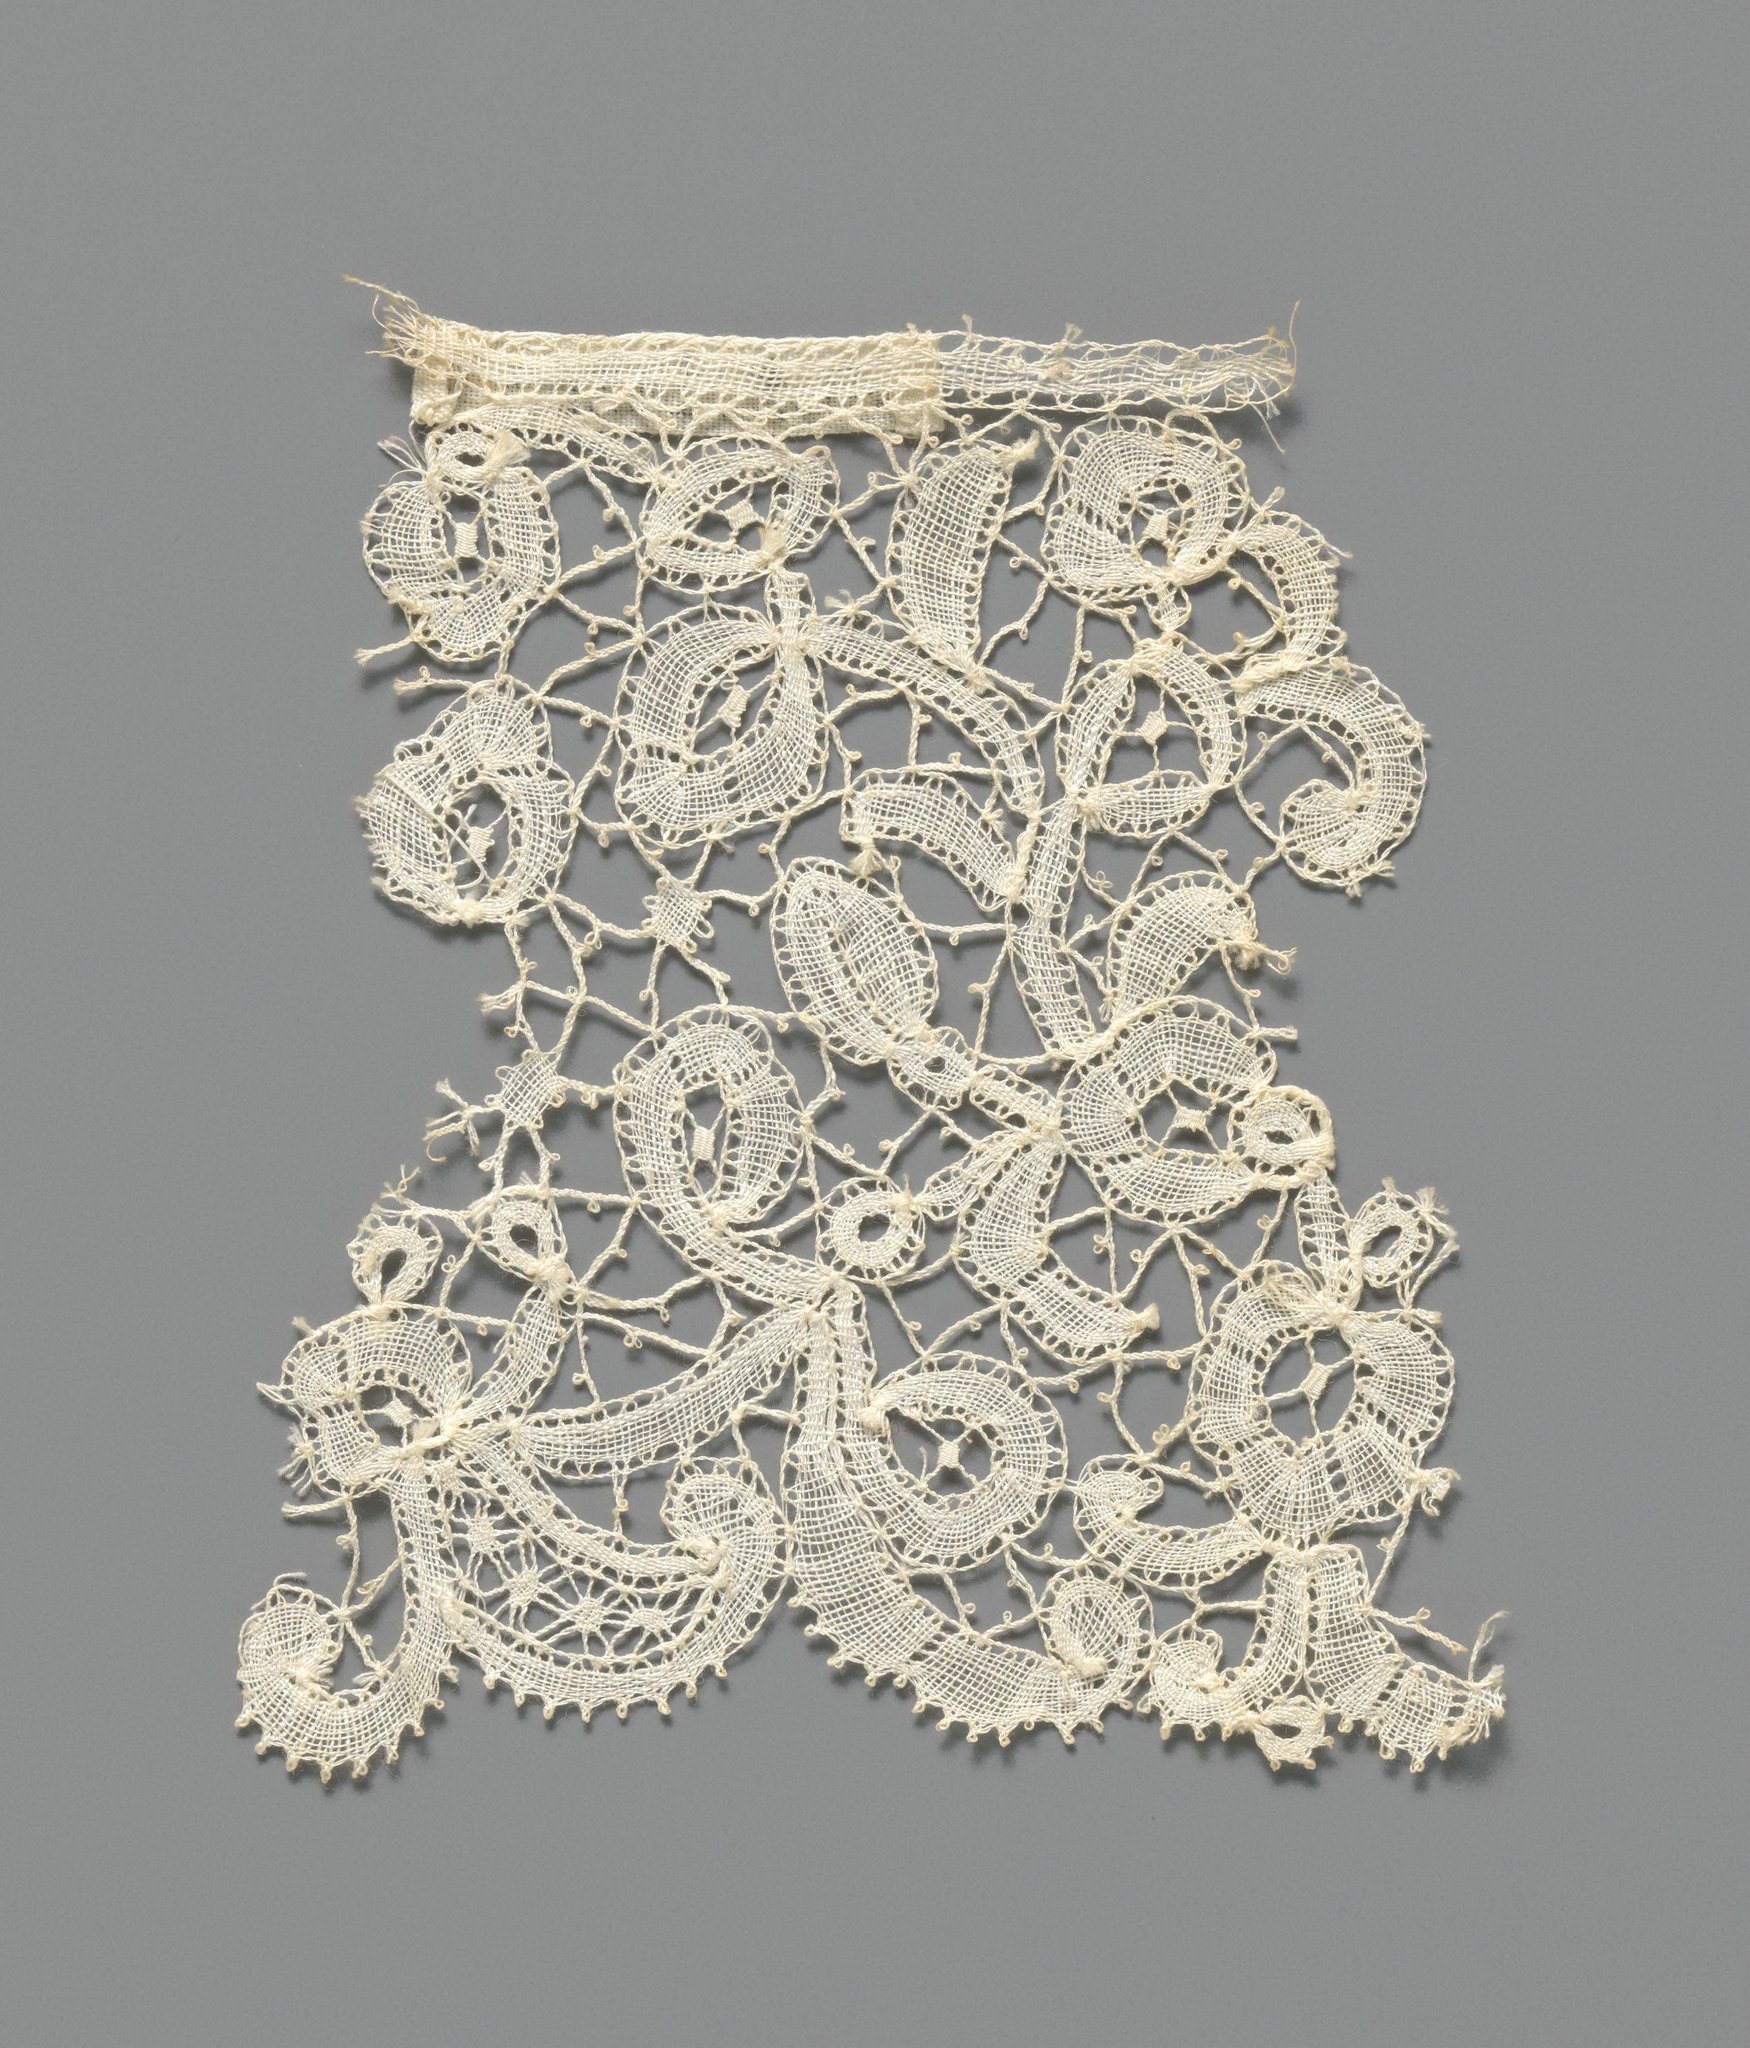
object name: strip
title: Strook kloskant met verschillende ovale bloempjes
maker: Anonymous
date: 1925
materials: linen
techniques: lace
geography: bruges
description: Strook naturelkleurig kloskant: fijn Brugs bloemwerk. Het patroon dat te zien is op het korte stuk strook bestaat uit verschillende ovale bloempjes die met korte ranken en blaadjes met elkaar verbonden zijn. De motieven zijn gemaakt in linnenslag, met opengewerkte randjes en dunne contourdraden. De motieven zijn met elkaar verbonden door een gepicoteerde vlechtengrond. Tussen de vlechten zijn enkele 'matjes' te zien, een soort vlakjes in linnenslag die lijken op spinnen. In de bloemharten zijn blokjes gemaakt in vormslag of in linnenslag. In een voluutblad is een siergrondje met spinnen toegepast. De bovenzijde van de strook is recht afgewerkt. De schulpenrand is afgewerkt met picots.